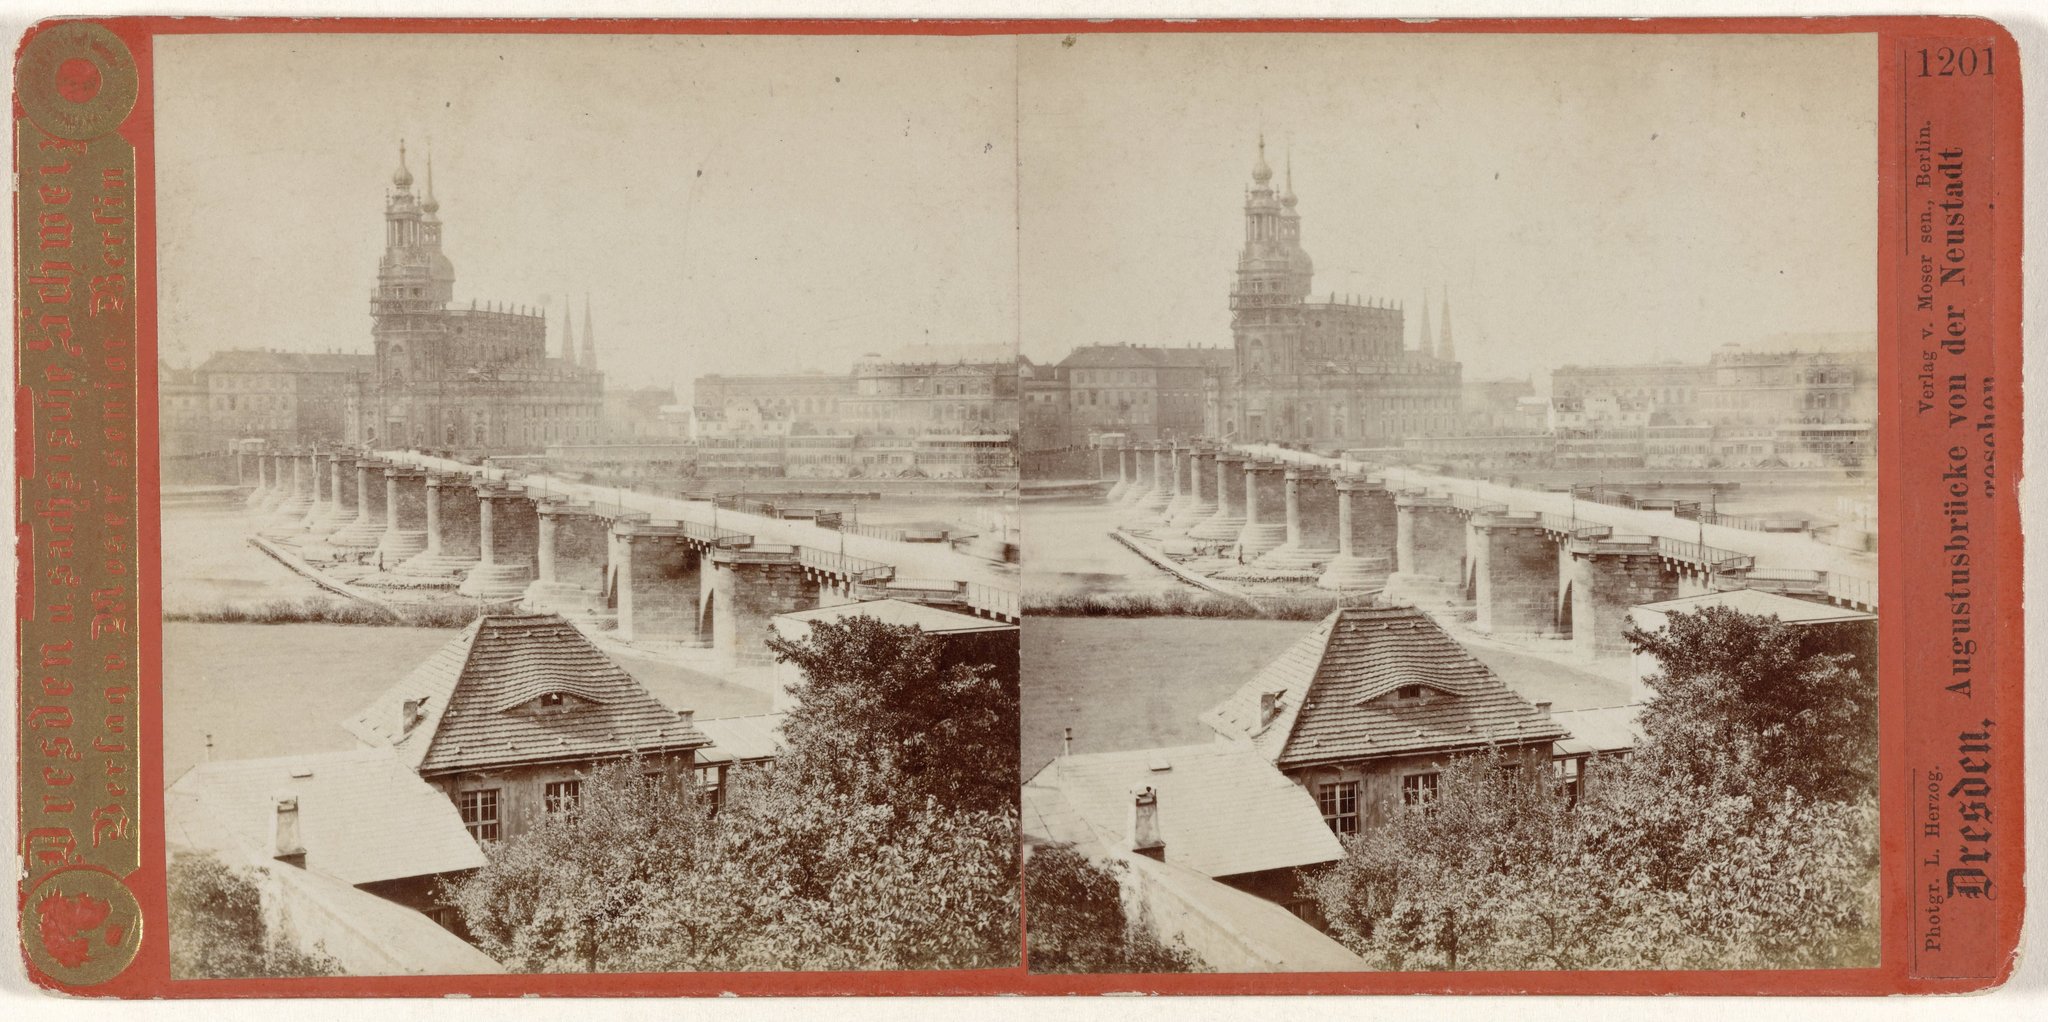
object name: stereograph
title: Dresden, Augustusbrücke von der Neustadt gesehen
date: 1873-1882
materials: cardboard, paper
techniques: albumen print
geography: berlin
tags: church (exterior), bridge in city across river, canal, etc.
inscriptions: inscription: ‘Photographiser und Stereoscopischer/ Kunstverlag/ von/ Moser senior/ (...)/ Glas-u. Papier-Stereoscopbildern/ aller Weltgegenden’, number: ‘1201’